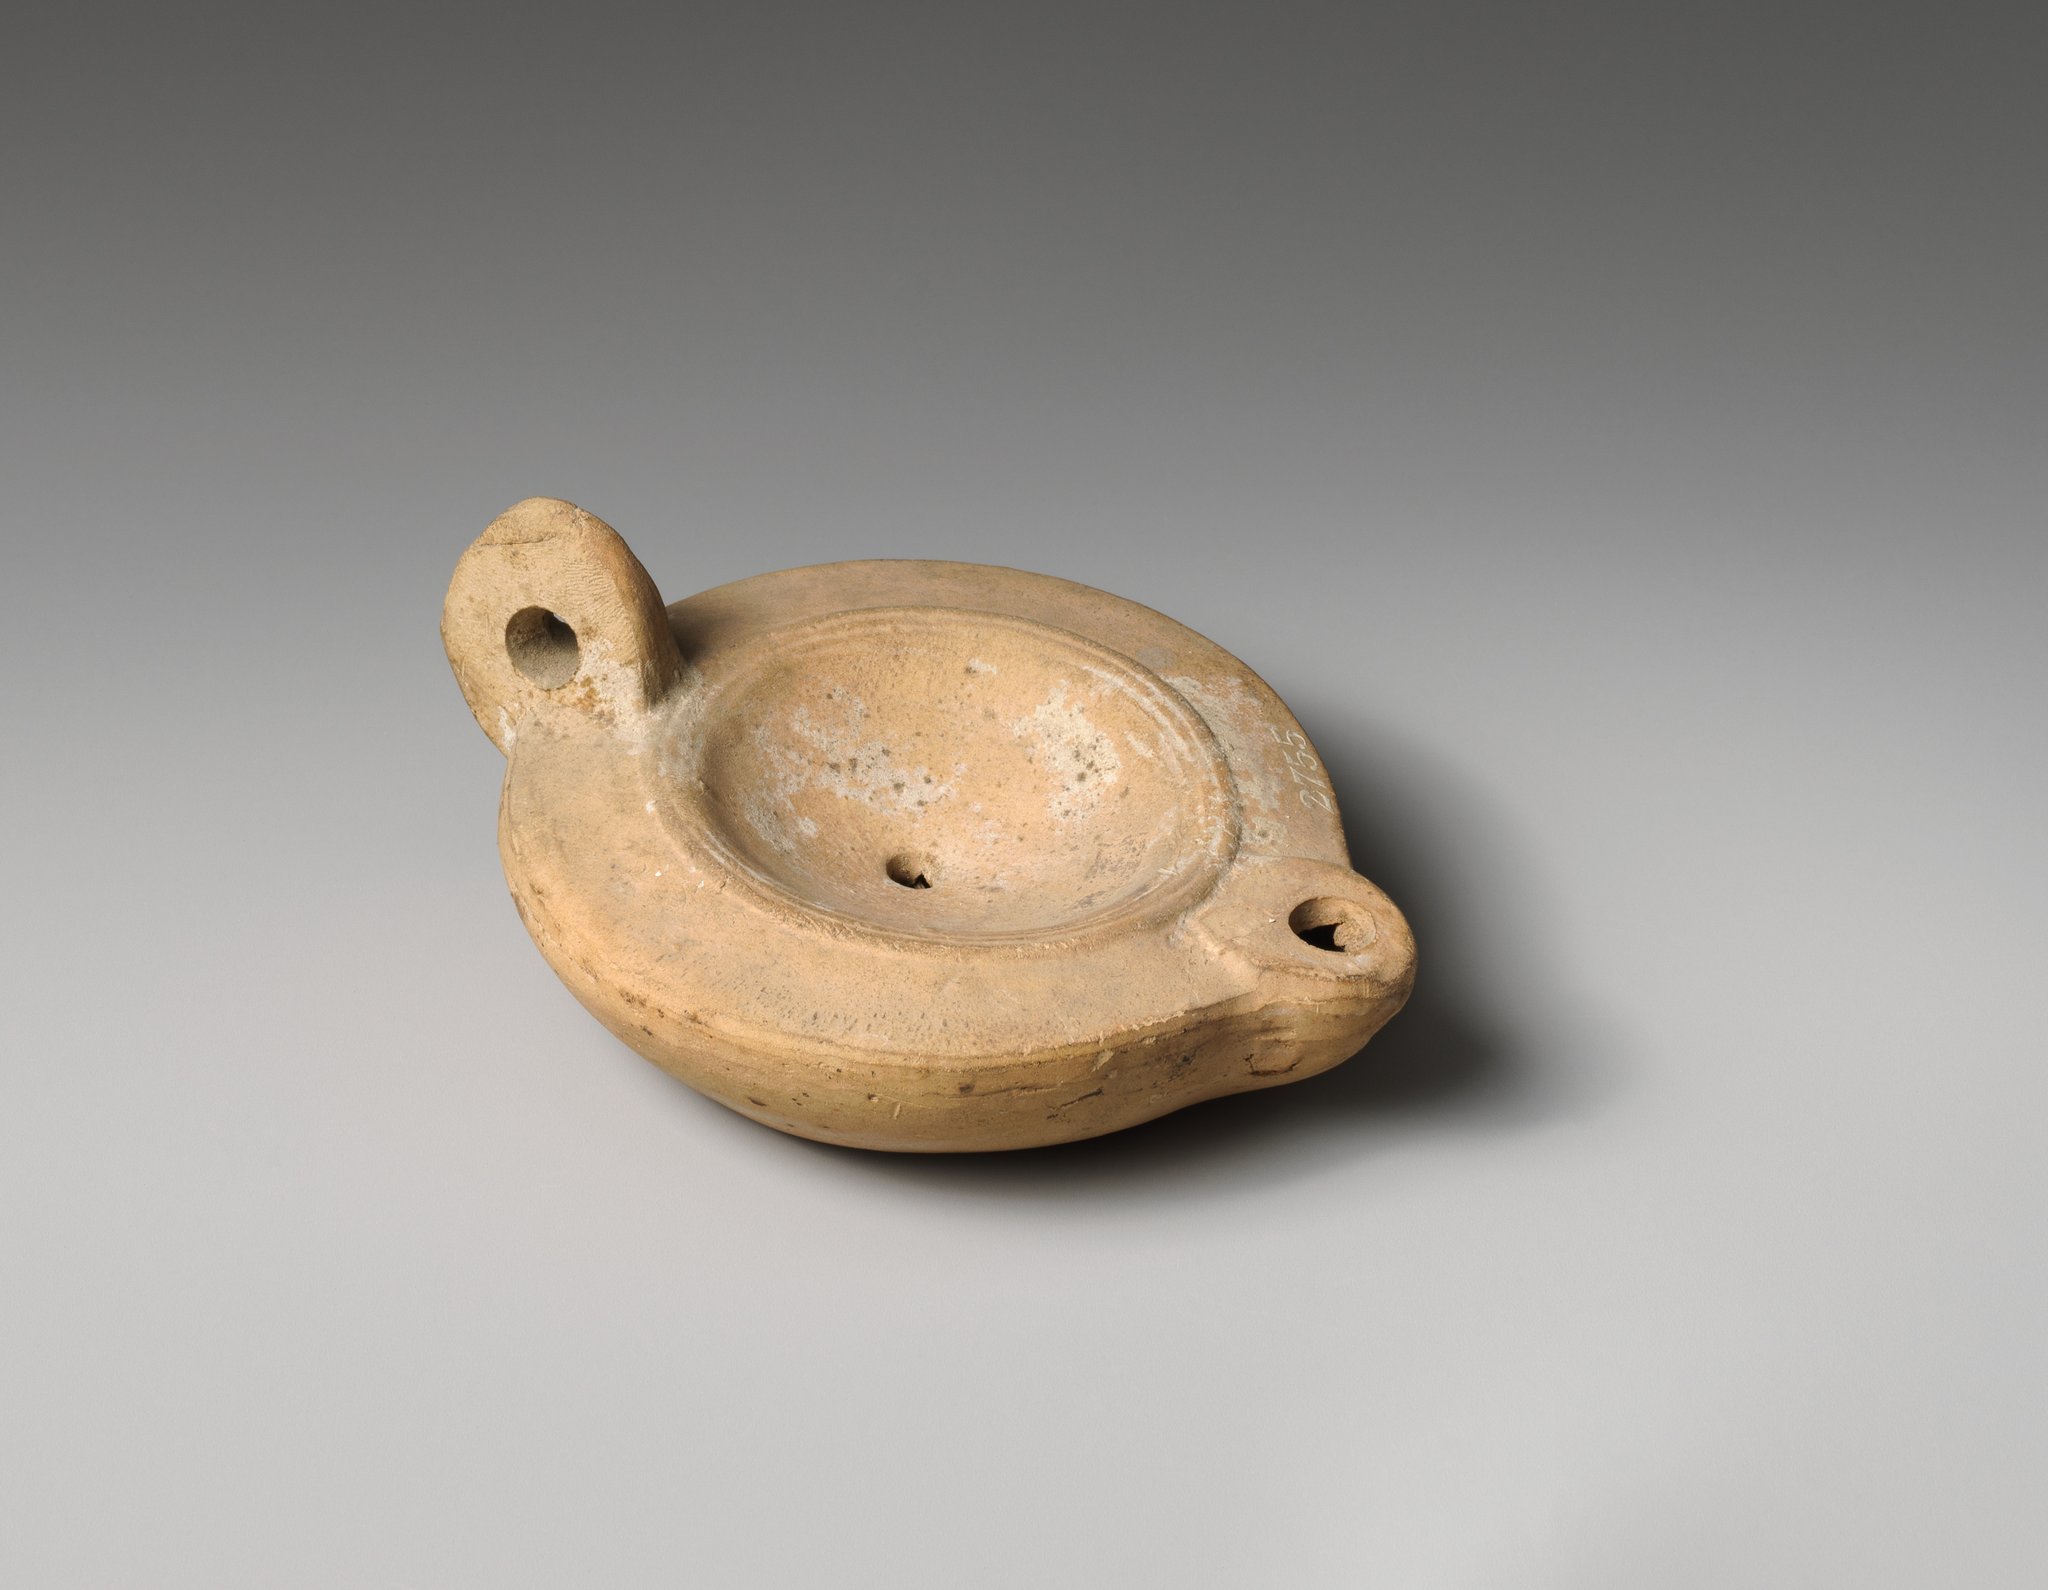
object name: lamp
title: Terracotta oil lamp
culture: roman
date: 101-200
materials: terracotta